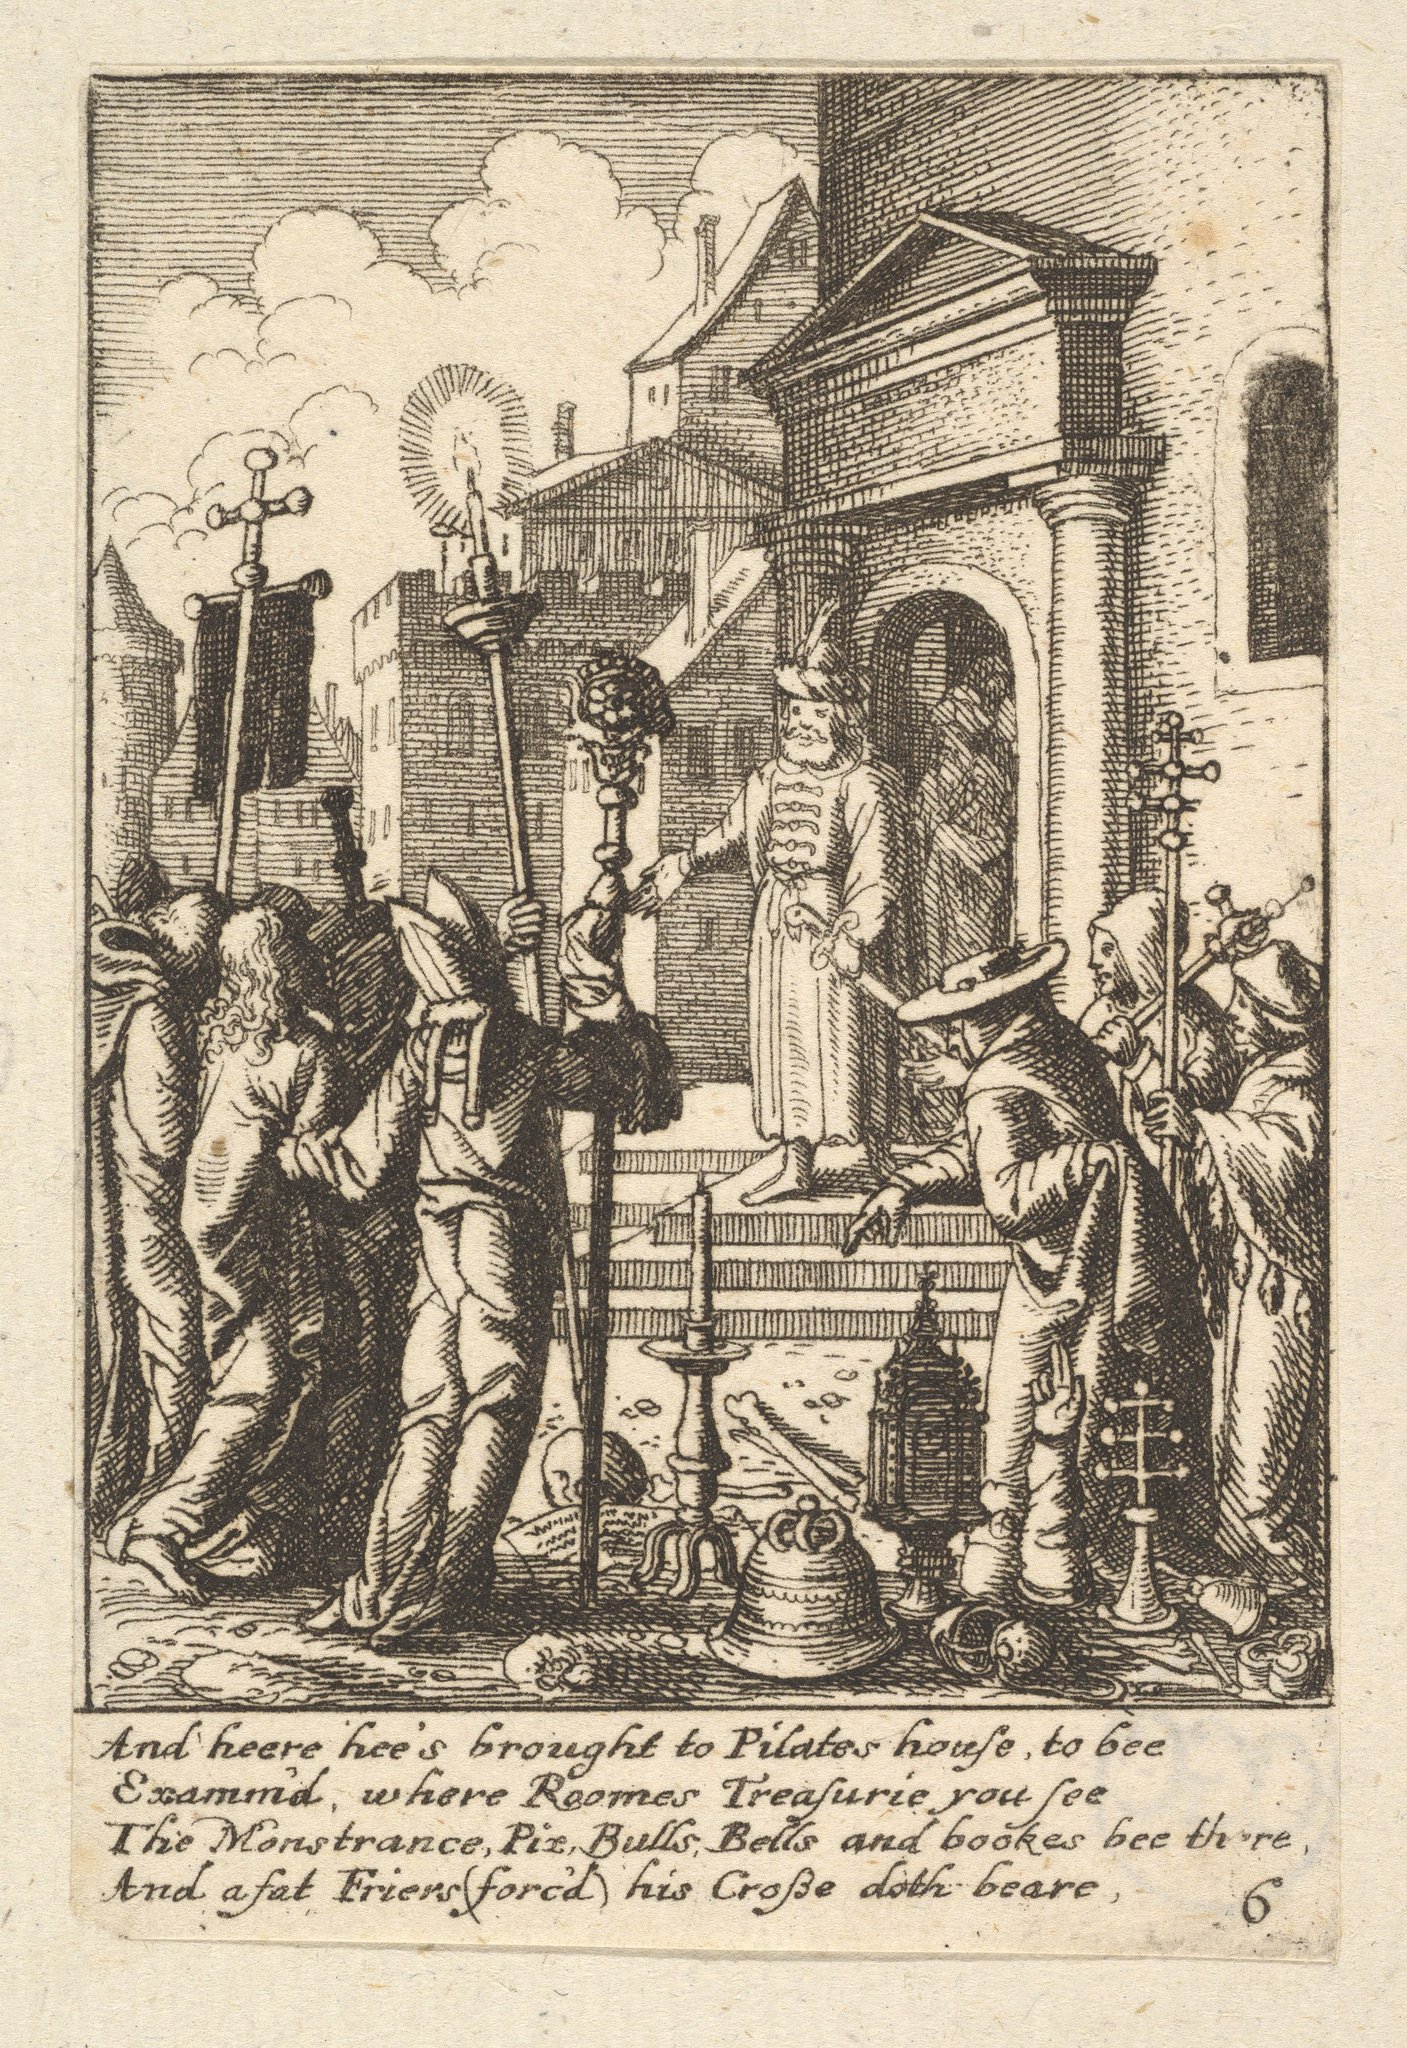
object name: print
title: Jesus before Pilate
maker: wenceslaus hollar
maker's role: artist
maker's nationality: bohemian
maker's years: 1607-1677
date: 1644-1652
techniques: etching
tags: men,jesus